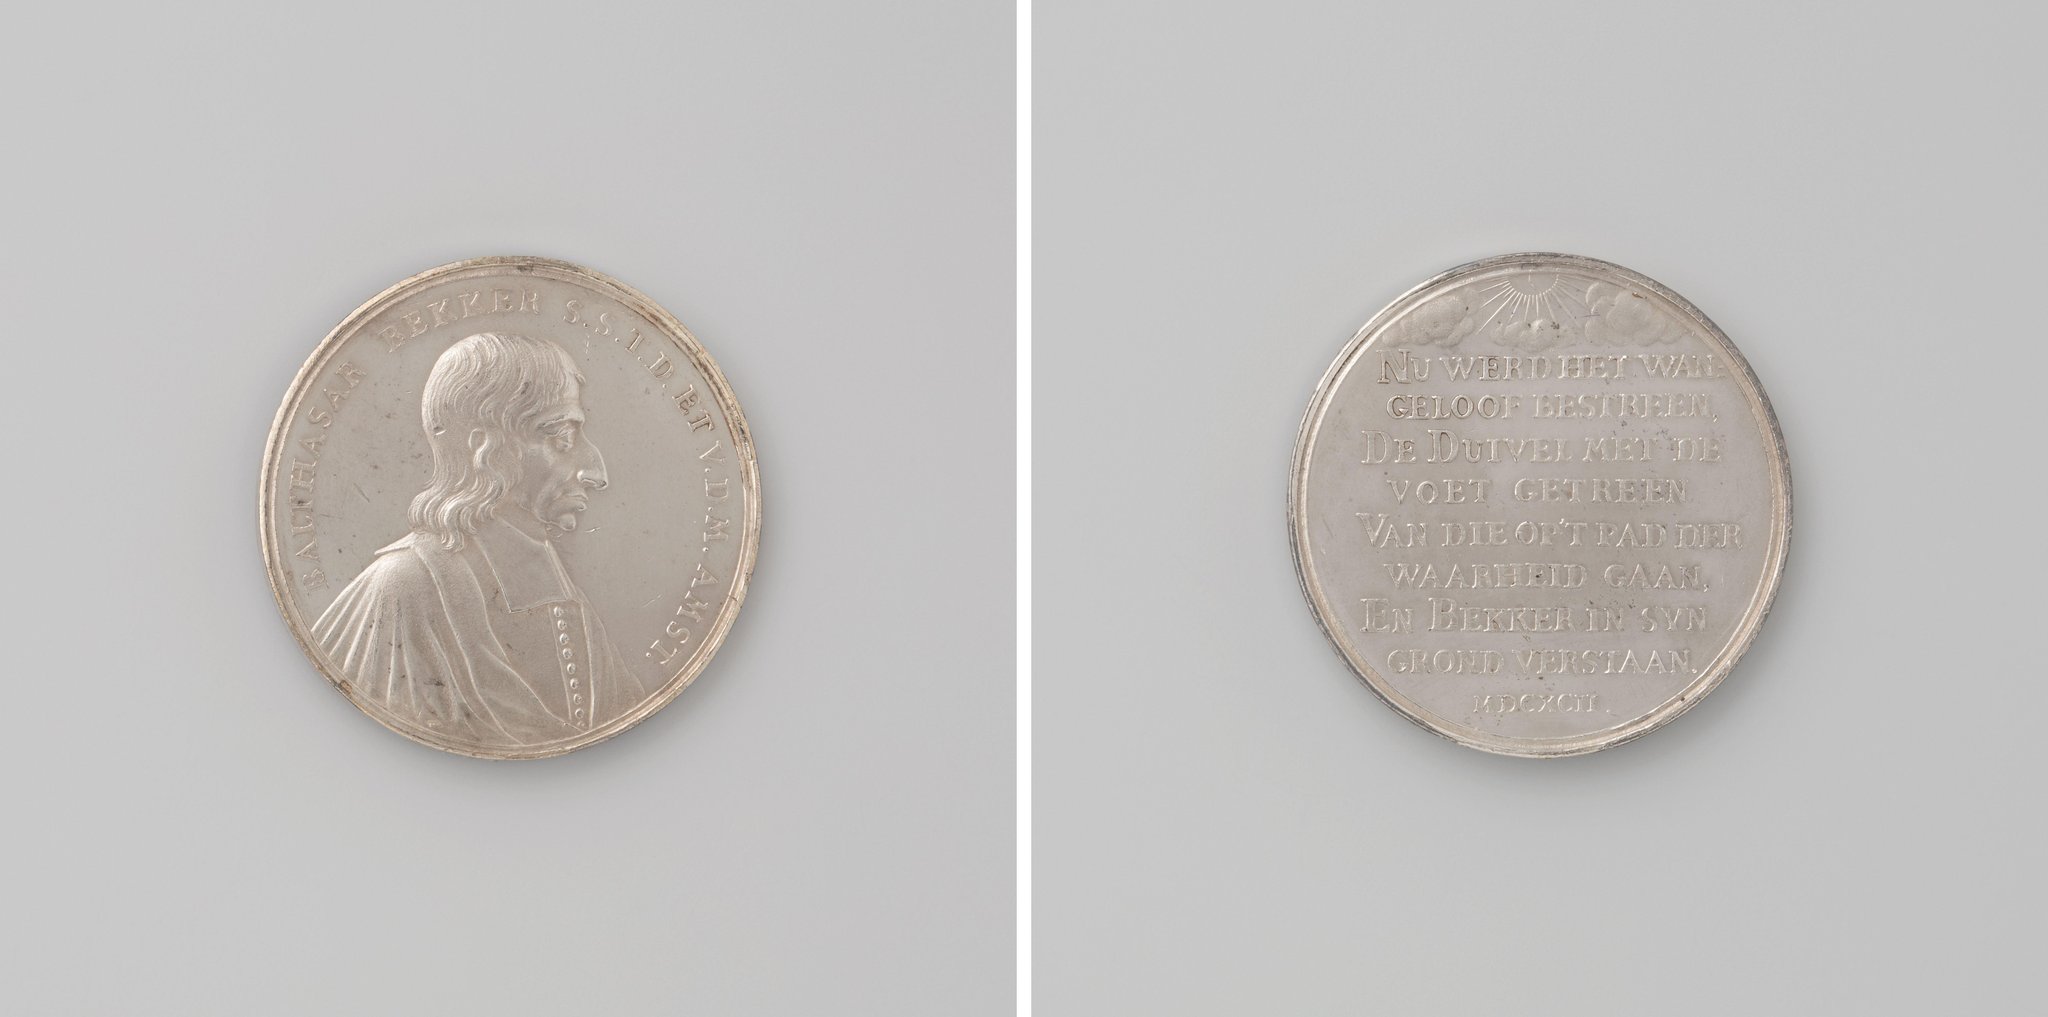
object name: history medal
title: Balthasar Bekker, predikant te Amsterdam, door de synode te Alkmaar afgezet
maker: franciscus de winter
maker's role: medailleur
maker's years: 1649-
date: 1692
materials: silver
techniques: striking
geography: netherlands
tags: amsterdam, balthasar bekker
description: Zilveren penning. Voorzijde: borststuk man binnen omschrift. Keerzijde: opschrift onder door wolken heen brekende zon